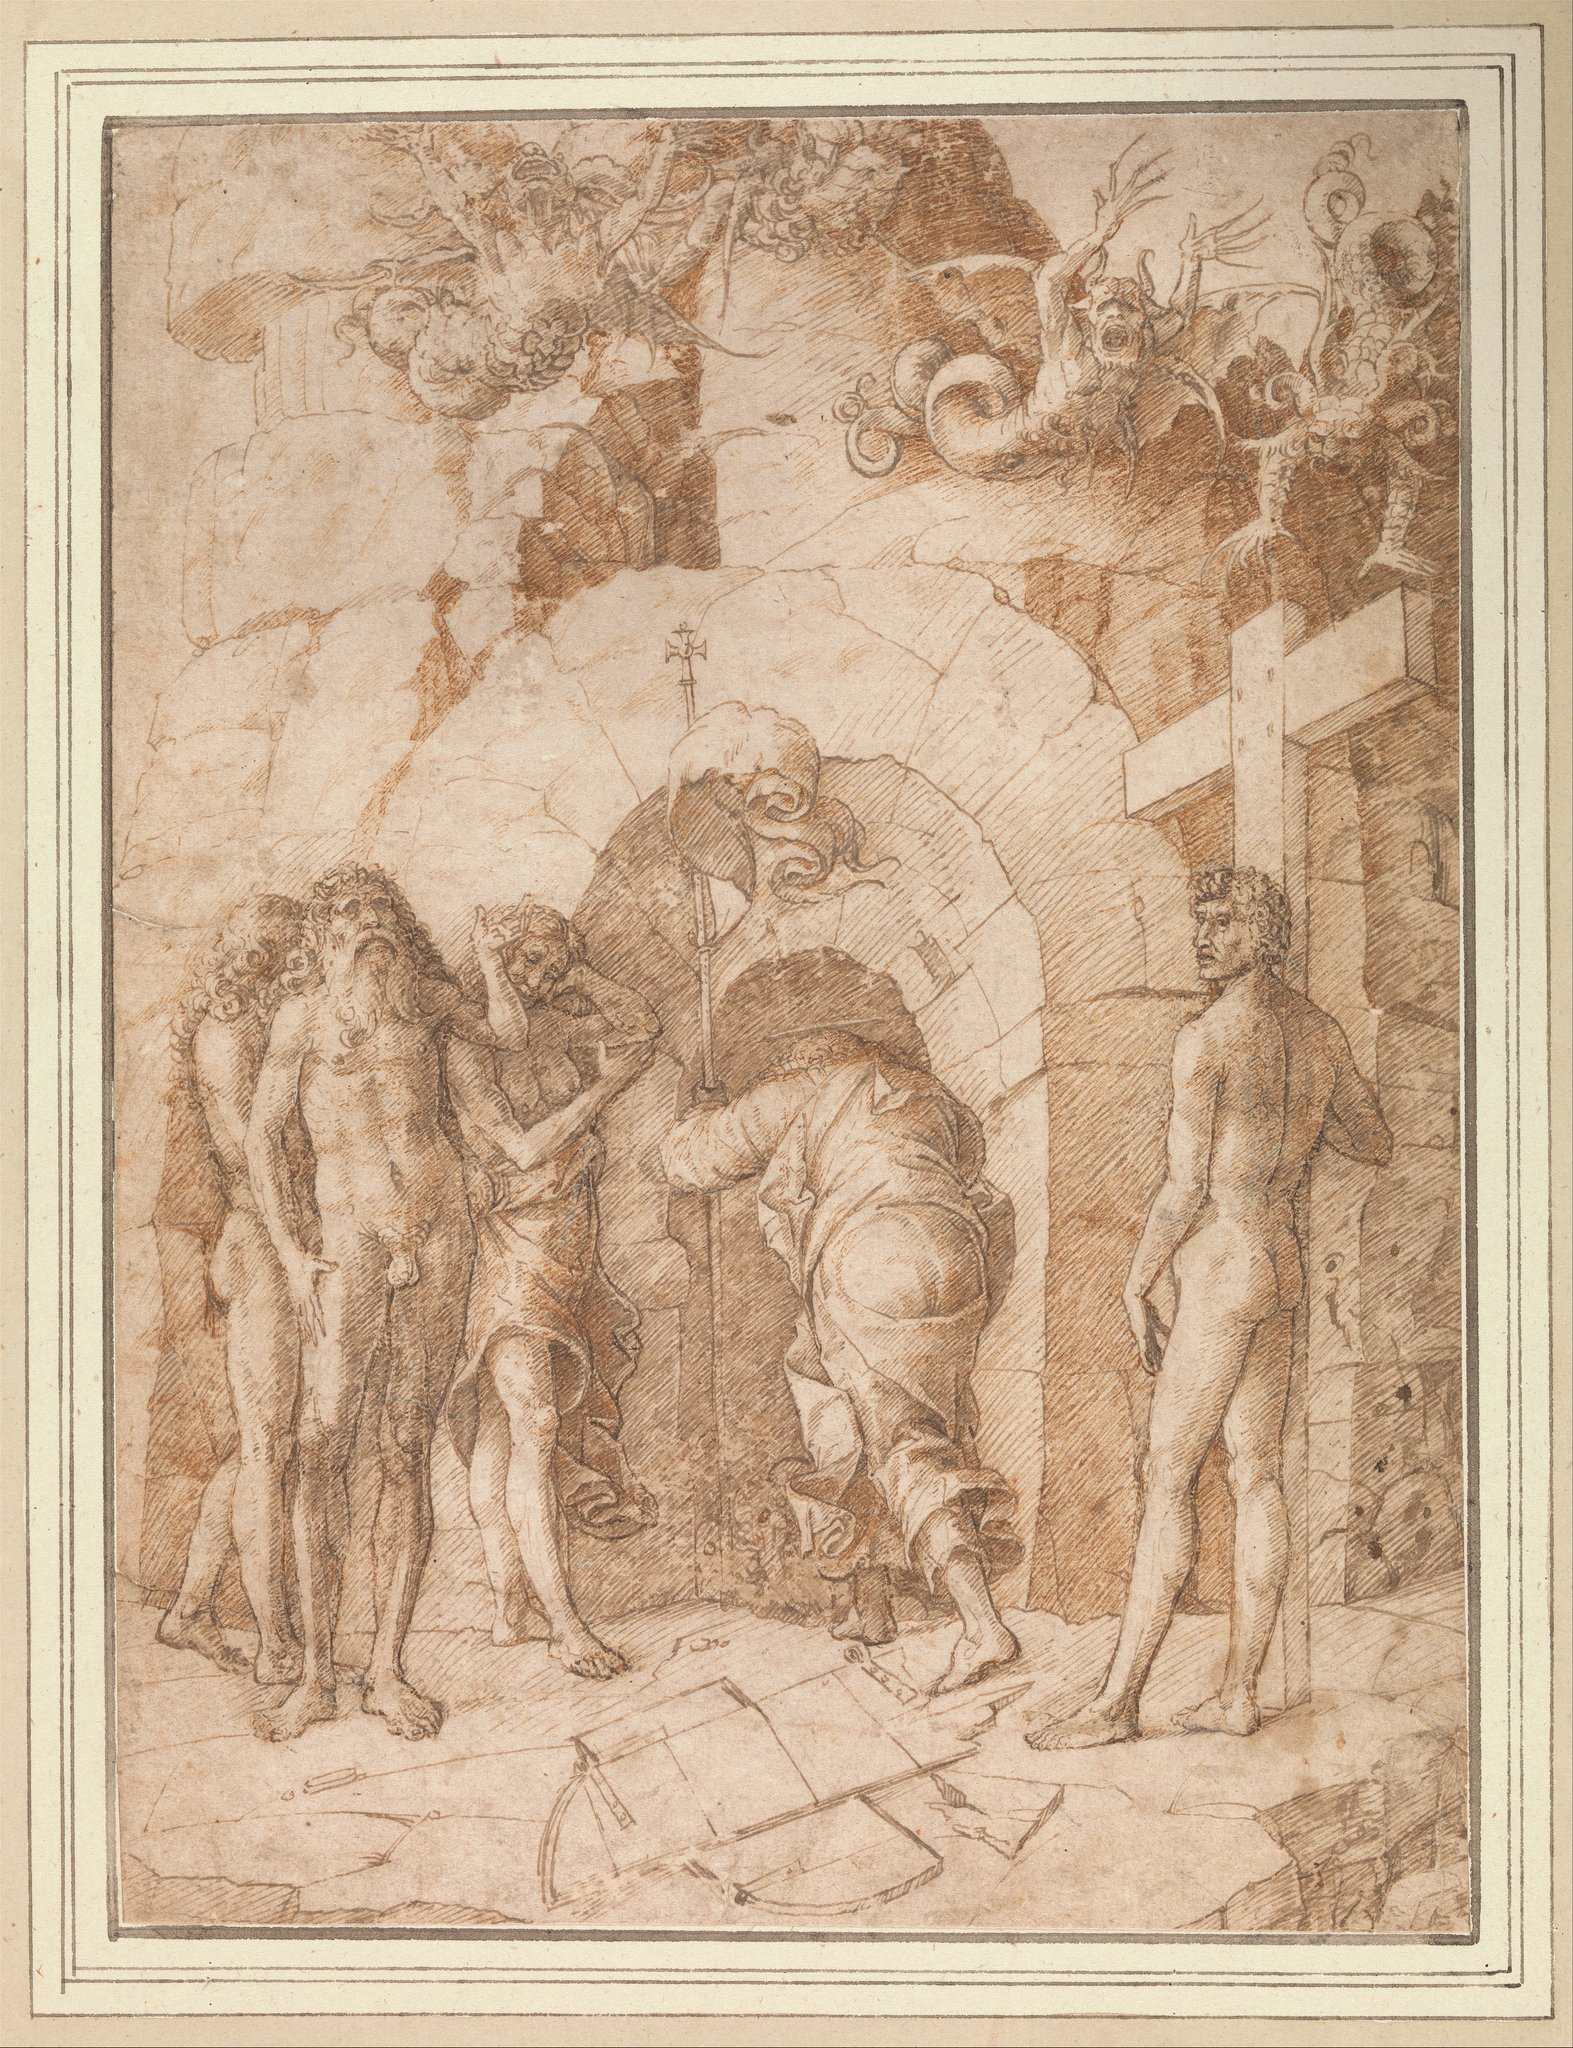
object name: drawing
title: The Descent into Limbo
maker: andrea mantegna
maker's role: artist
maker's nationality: italian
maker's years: 1431-1506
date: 1434-1466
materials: ink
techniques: pen, wash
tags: male nudes,female nudes,christ